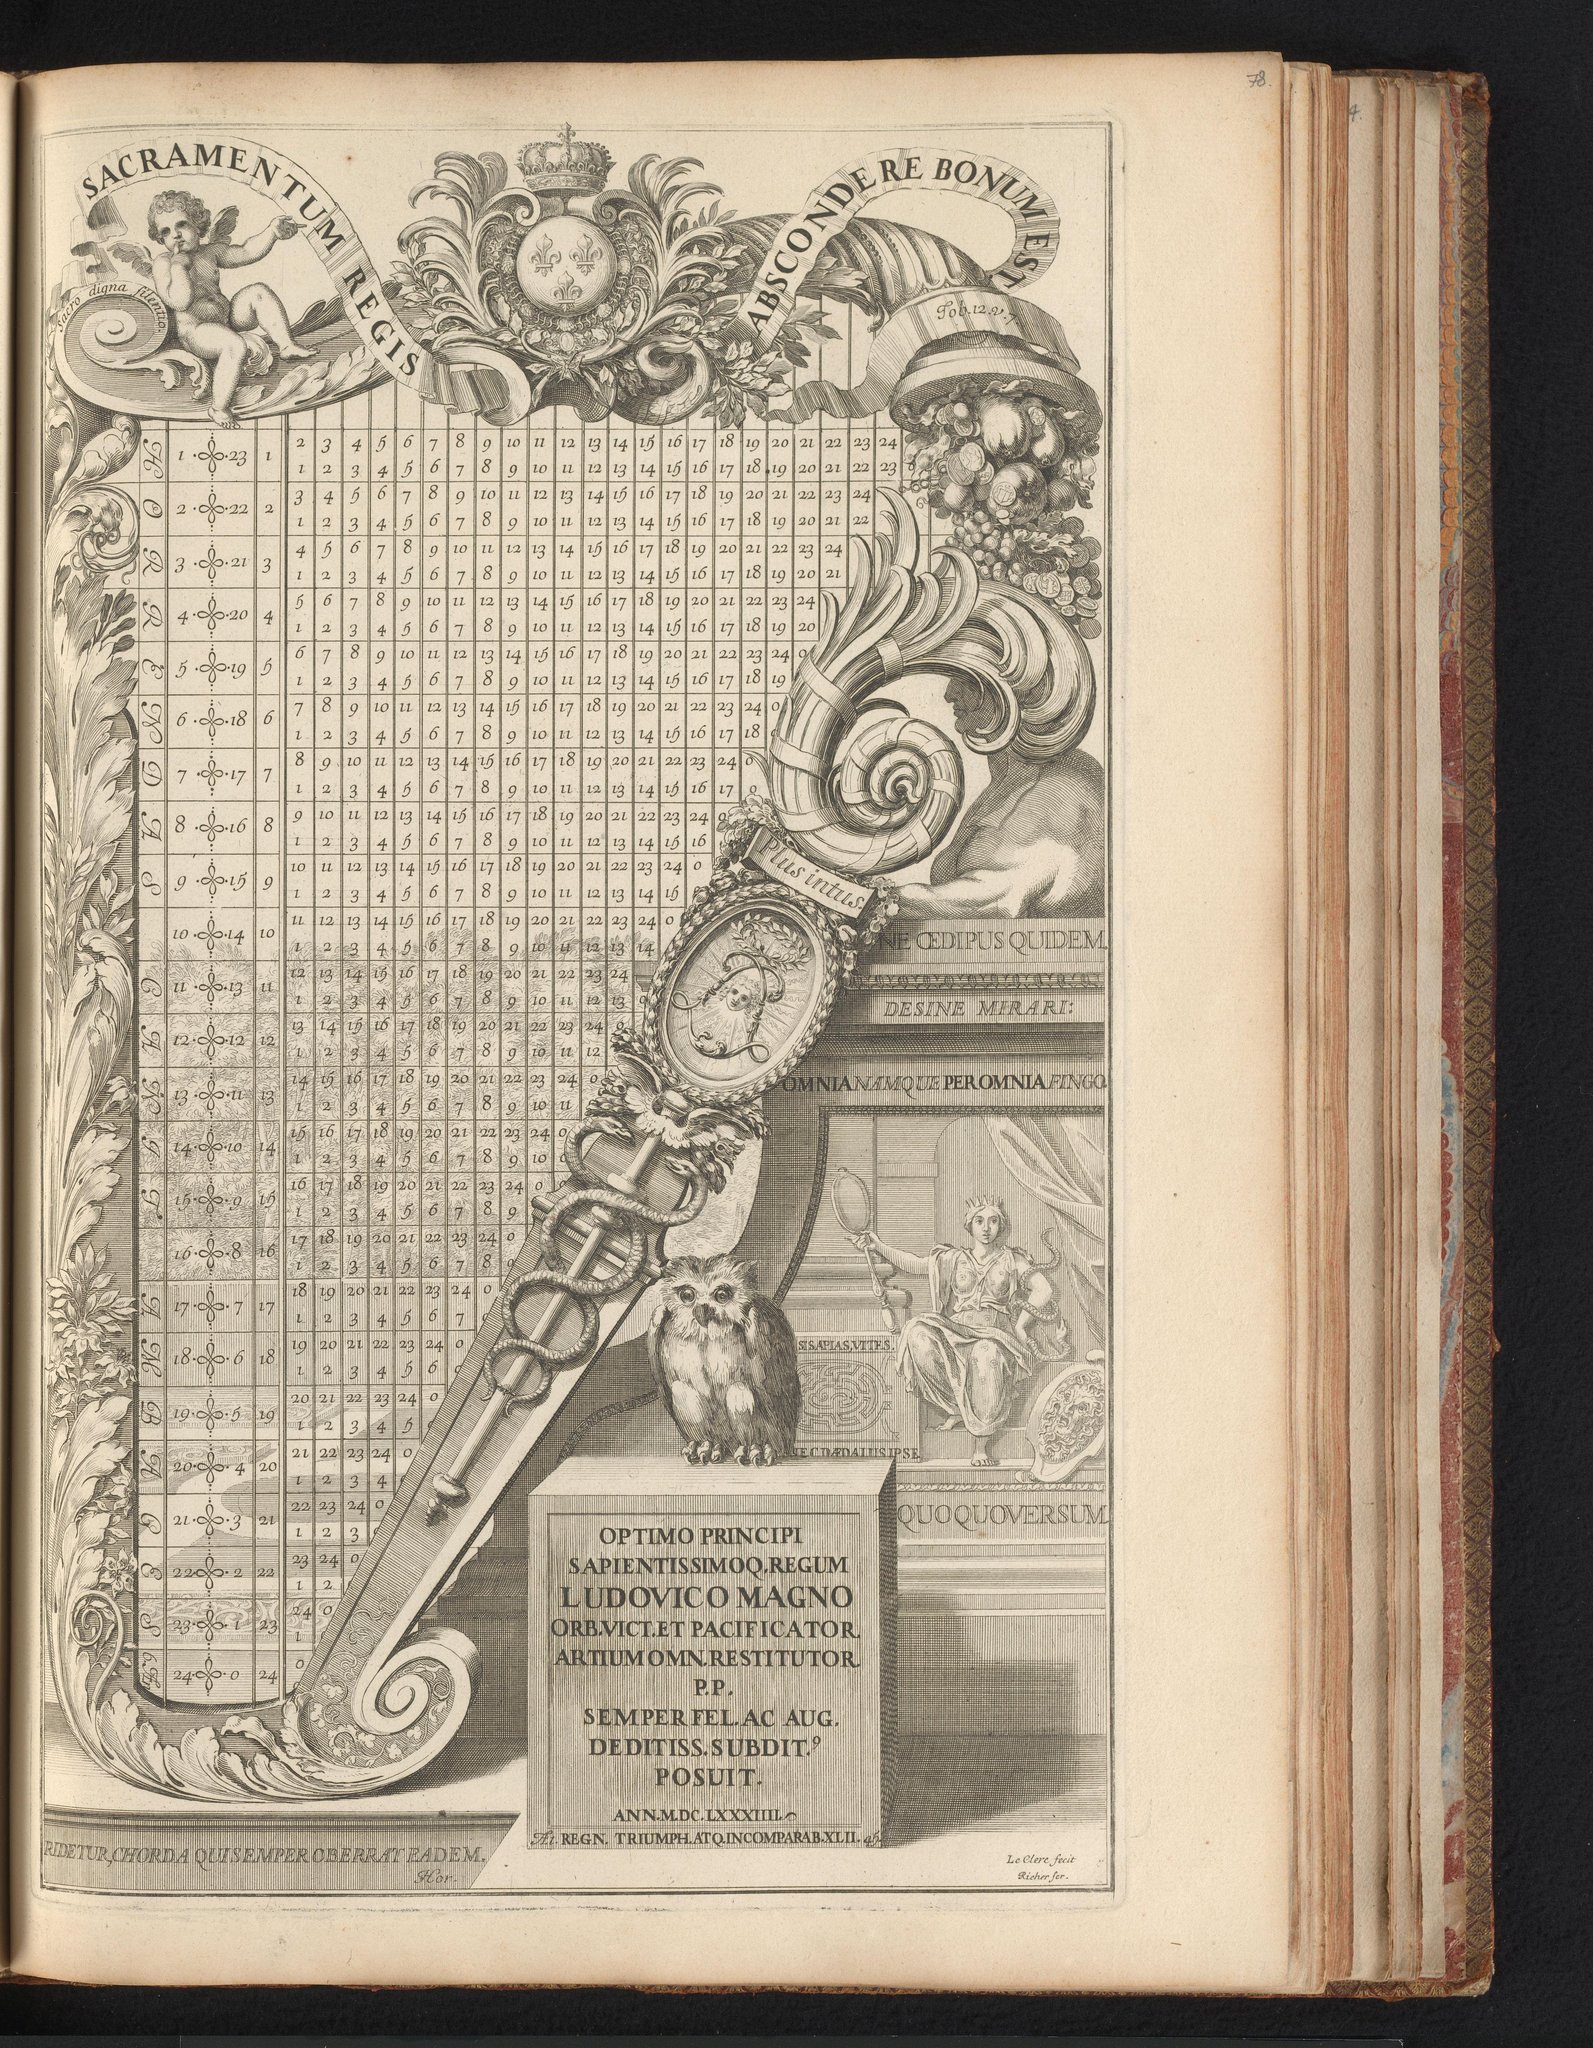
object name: album leaf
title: Sacramentum Regis Abscondere Boum est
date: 1684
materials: paper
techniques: engraving, etching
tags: lodewijk xiv (koning van frankrijk), sphinx (lion/woman); 'sfinge' (ripa) - aa - female human figure, historical persons, harp, owls, labyrinth, maze ~ garden, prudentia (prudence) as roman personification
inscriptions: date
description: Symbolische harp met in plaats van snaren een getallenschema. Het hout van de harp is versierd met symbolen die naar Lodewijk XIV verwijzen. Naast de harp een uil zittend op een sokkel, een sfinx, Prudentia en een doolhof. Prent maakt deel uit van een album.